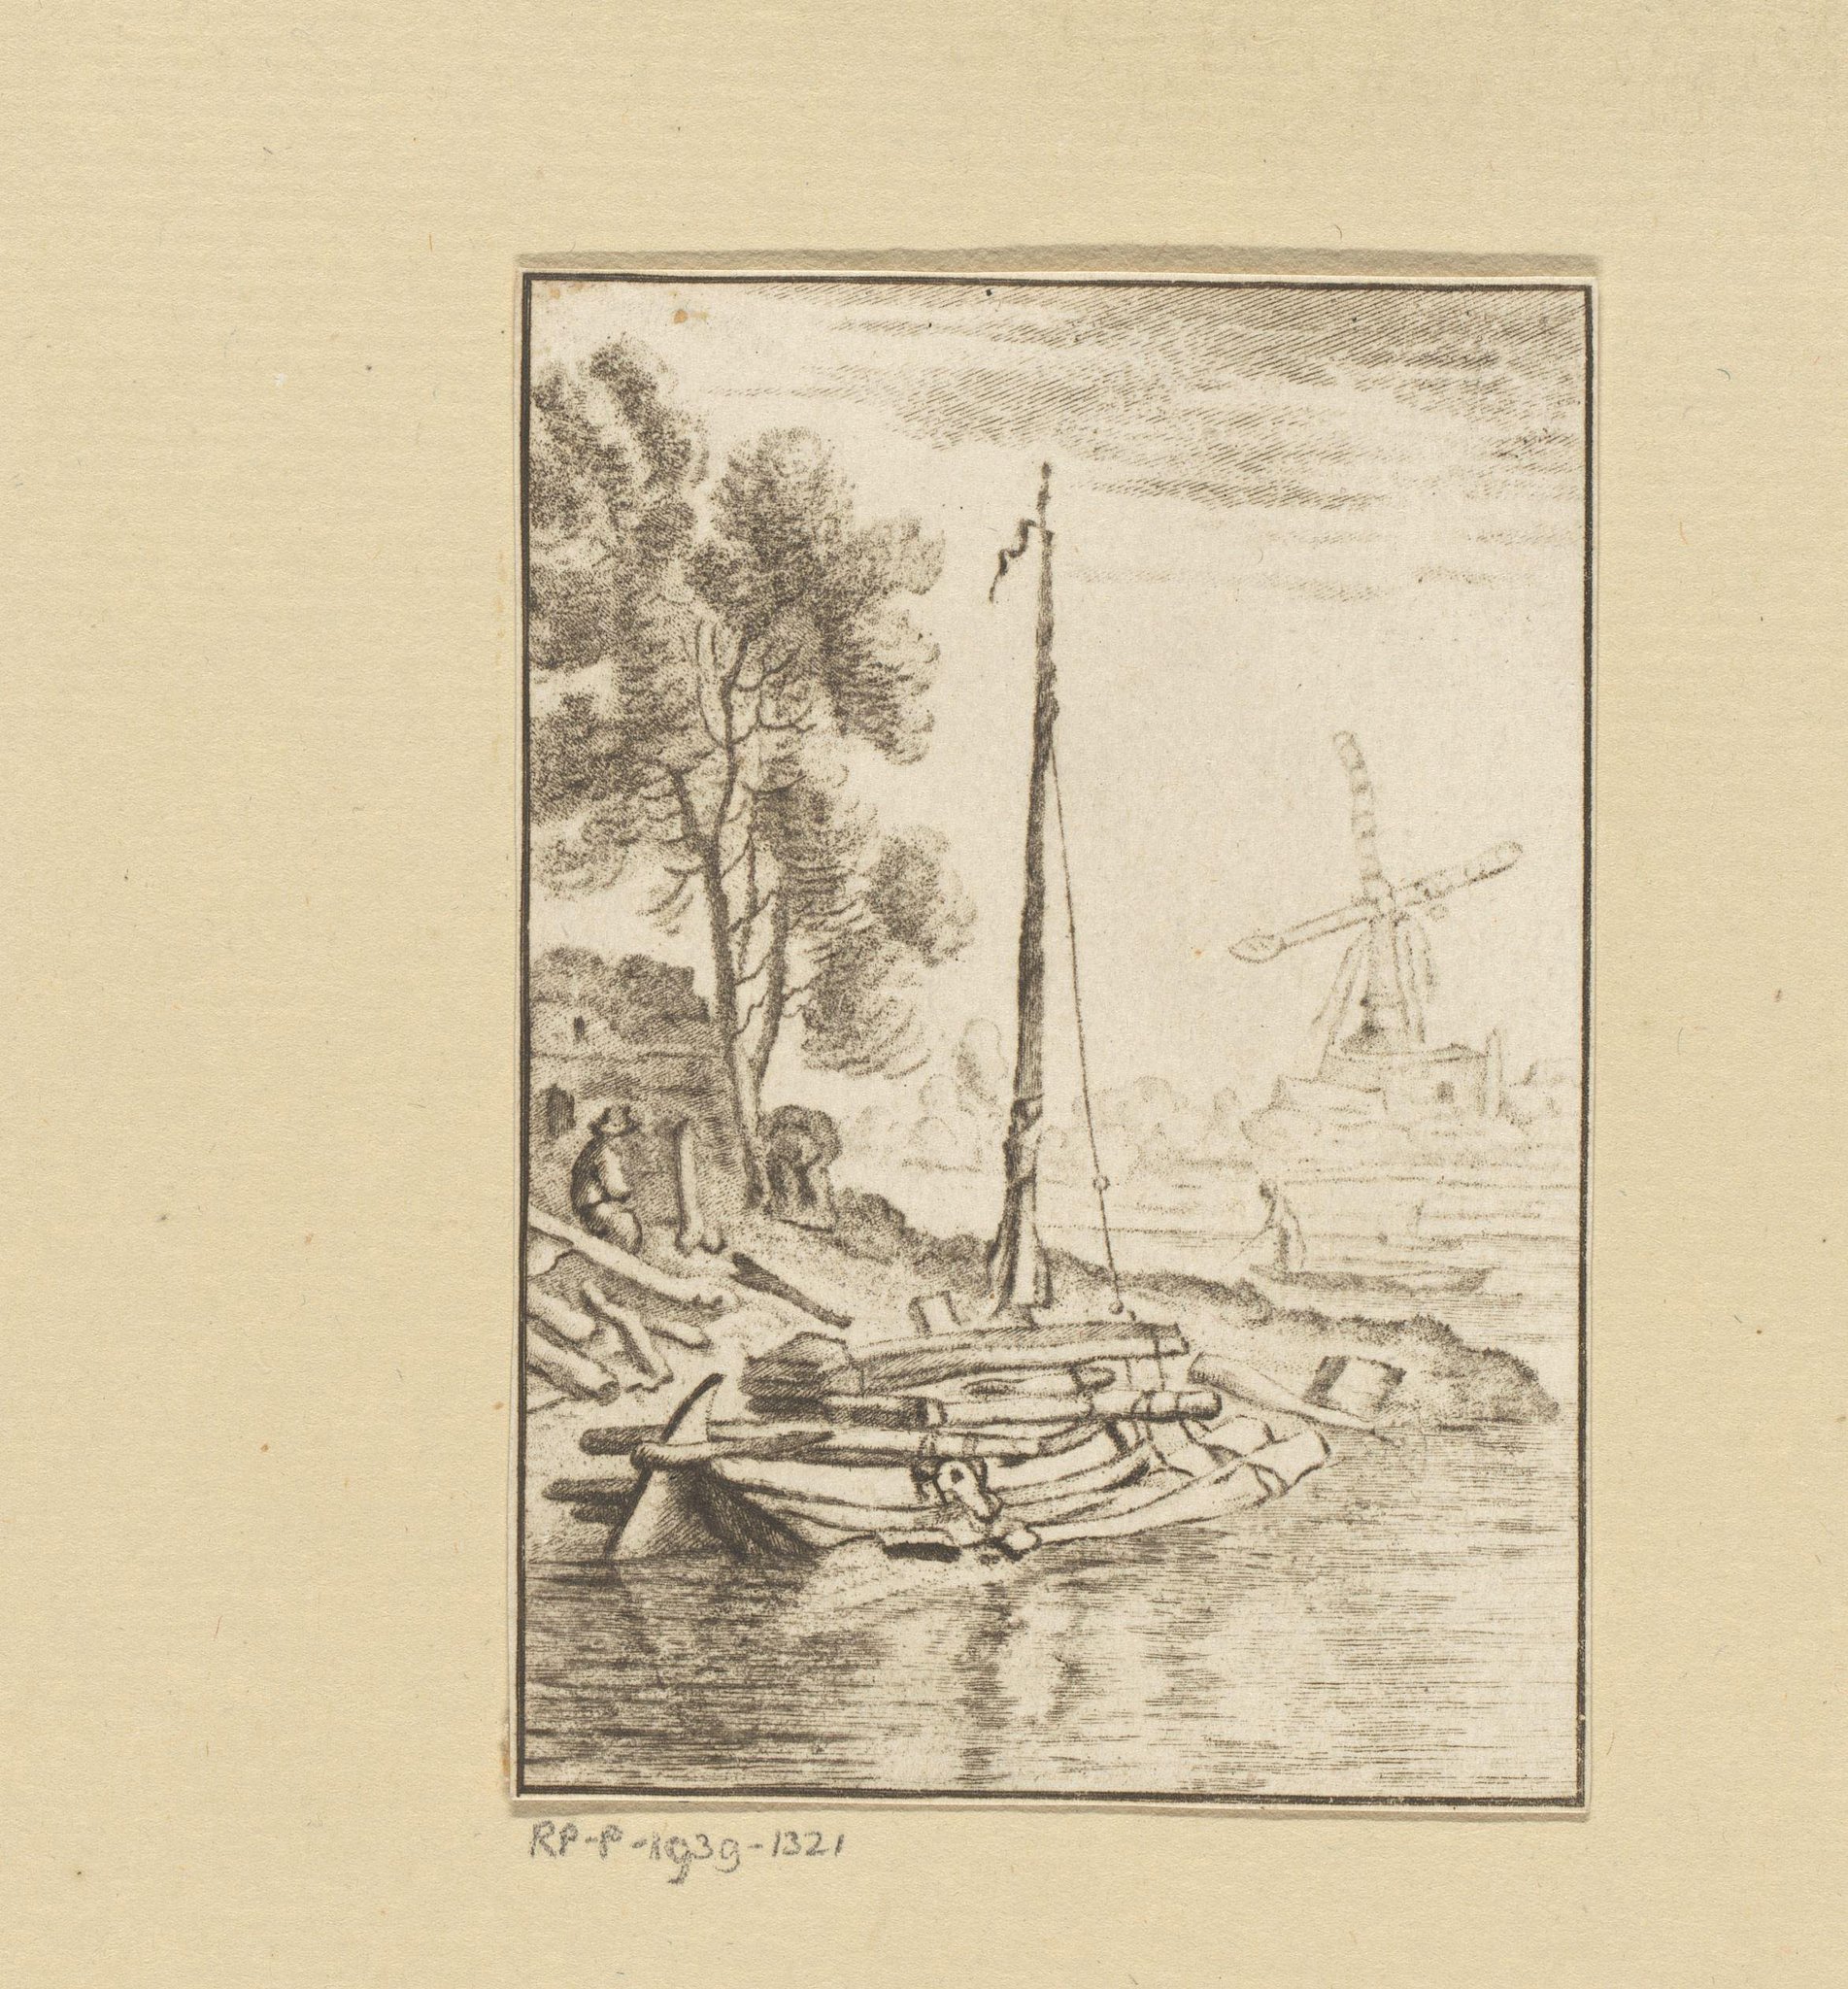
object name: print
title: Bochtige rivier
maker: cornelis ploos van amstel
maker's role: draughtsman, print maker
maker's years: 1726-1798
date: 1761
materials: paper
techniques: printmaking, etching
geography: amsterdam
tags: river, shipyard, shipdock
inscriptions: collector's mark: ‘RIJKS / MUSM’, collector's mark: Lugt 2725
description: De bocht van een rivier met links een scheepswerf en aan de overzijde een molen. De prent ligt los in een album, zie blad 3.